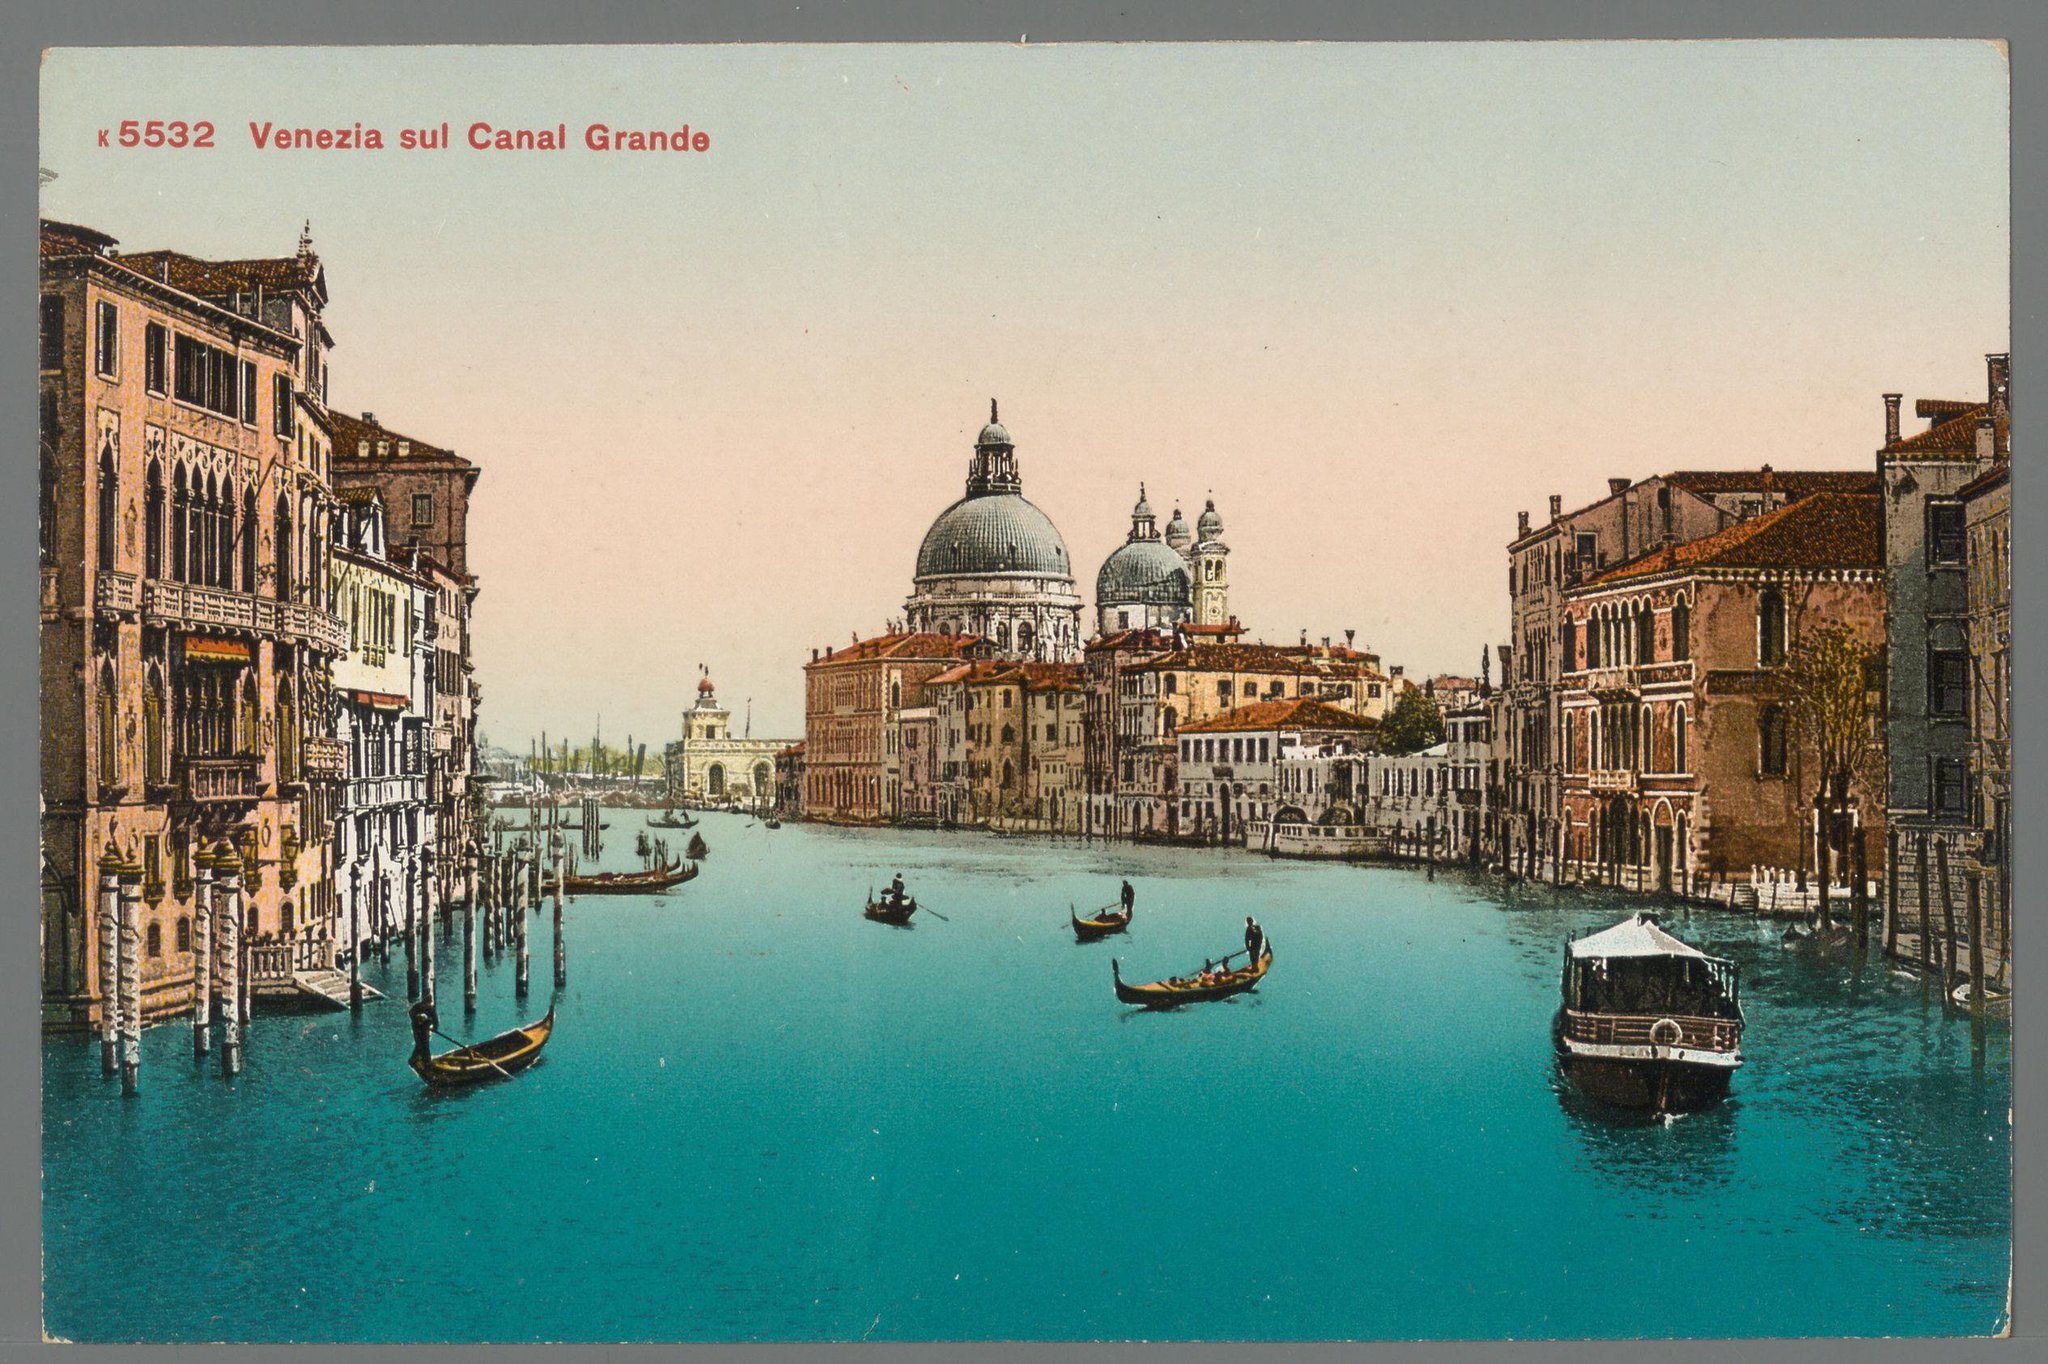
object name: photomechanical print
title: Venezia sul Canal Grande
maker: Anonymous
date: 1905-1930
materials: cardboard, photographic process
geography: venice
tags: canal, gondola, city-view, and landscape with man-made constructions (+ city(-scape) with figures, staffage)